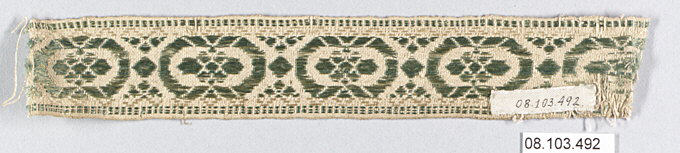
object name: galloon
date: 1701-1800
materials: cotton, silk